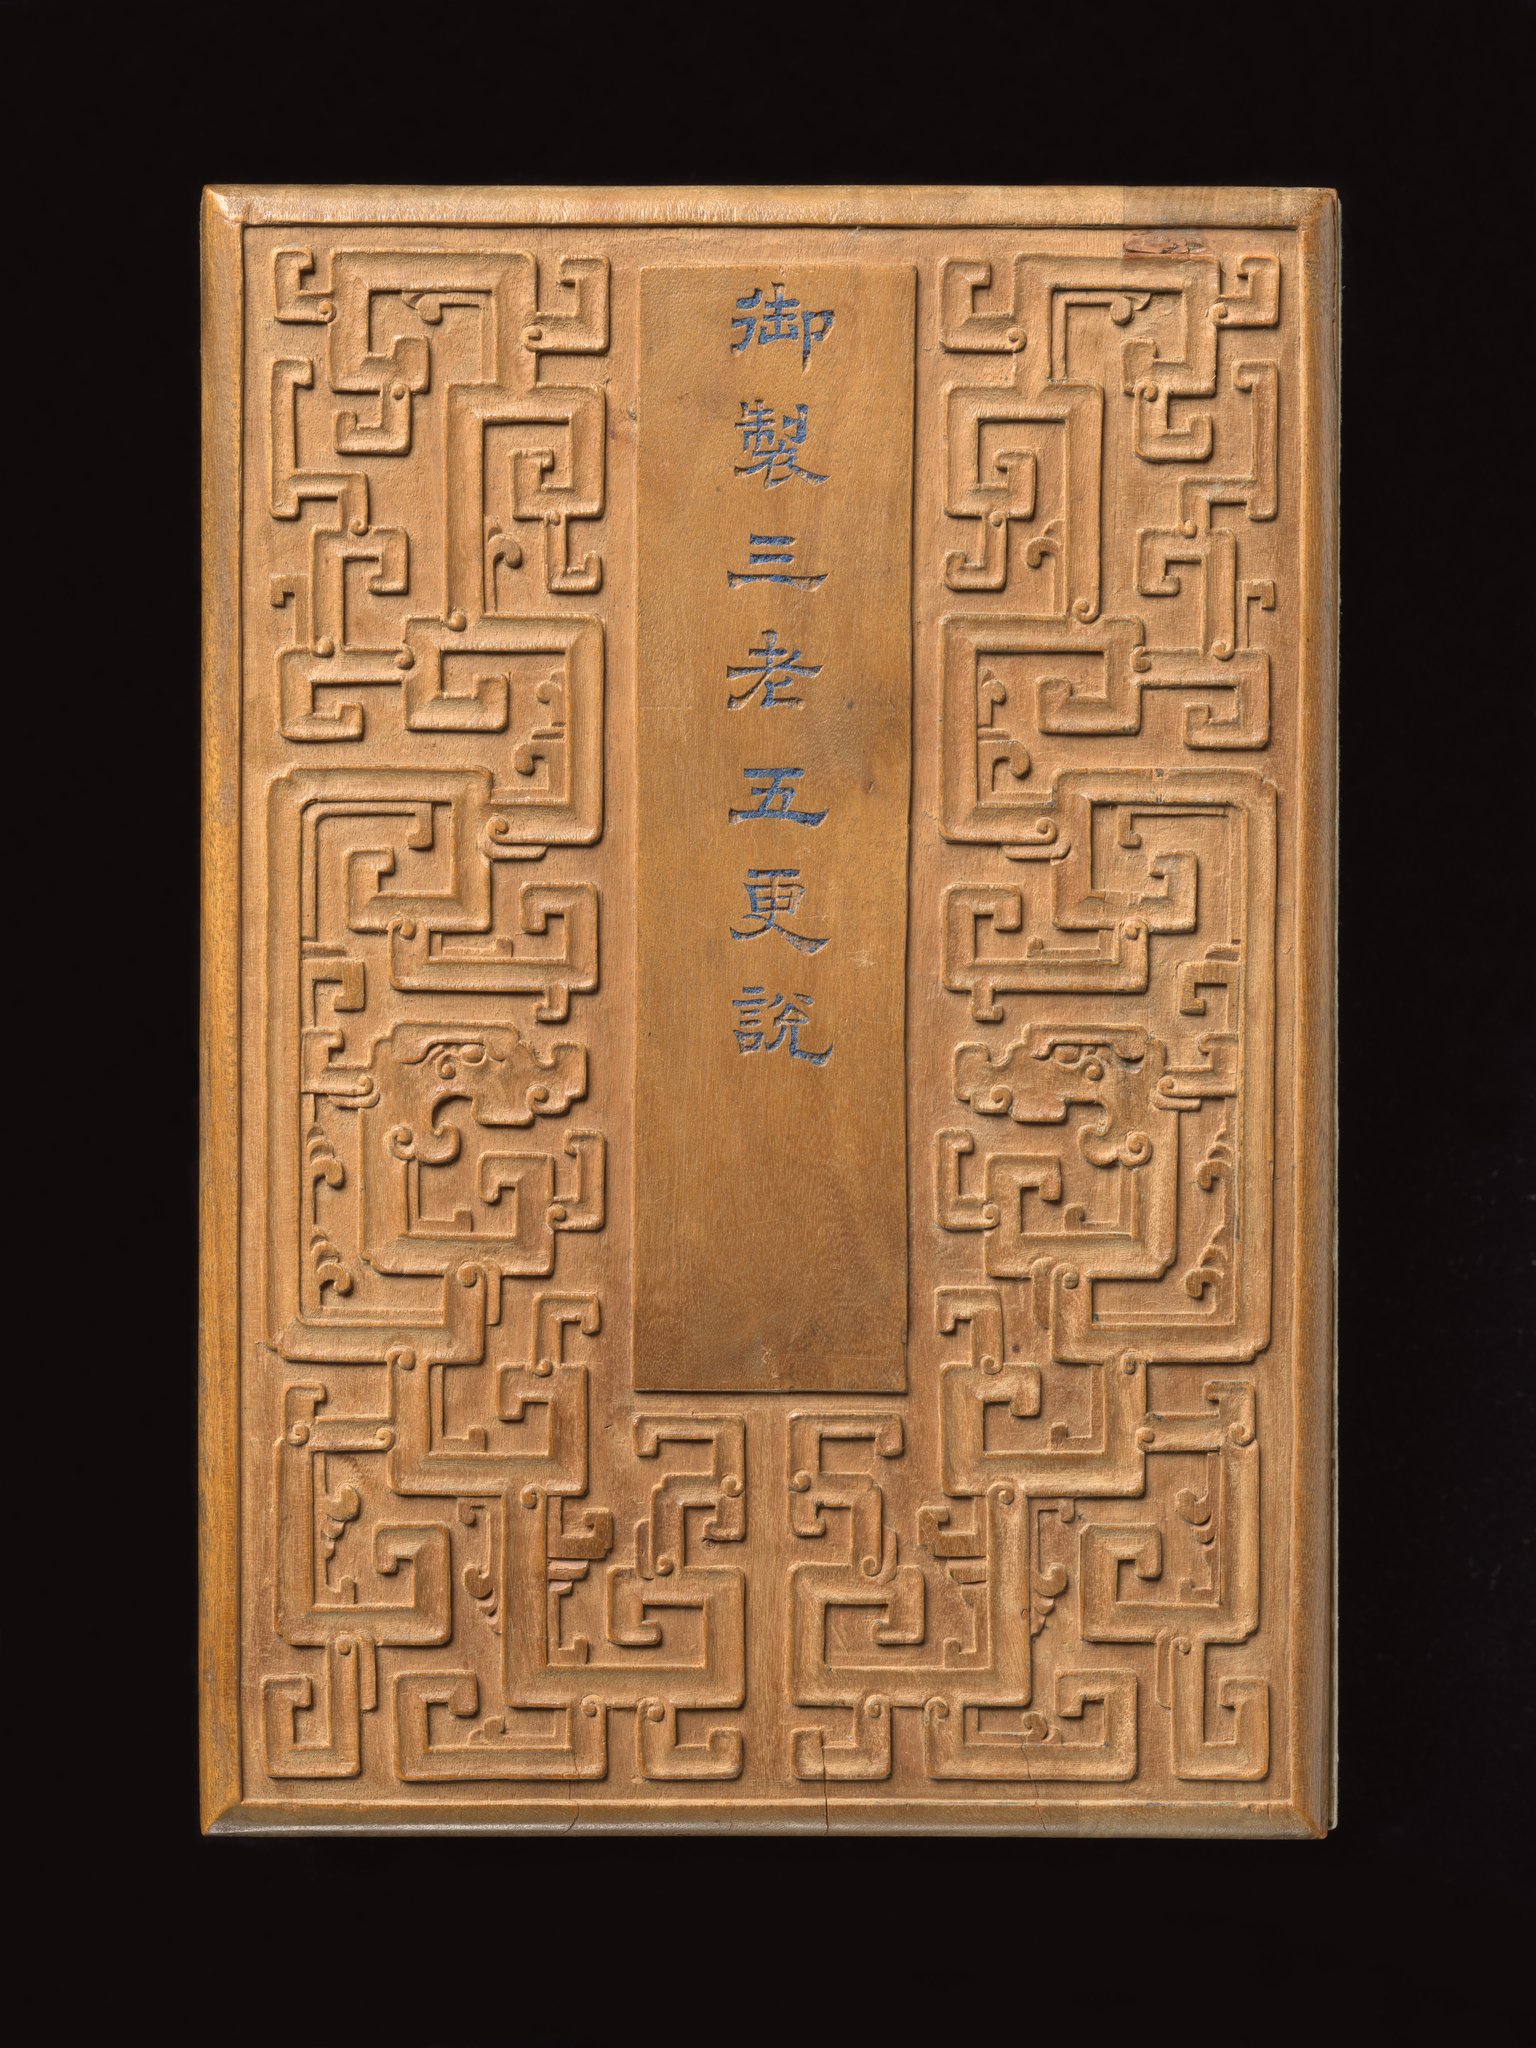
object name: book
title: Album of the Note on Respect of Elders composed by the Qianlong Emperor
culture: chinese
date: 1736-1795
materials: jade